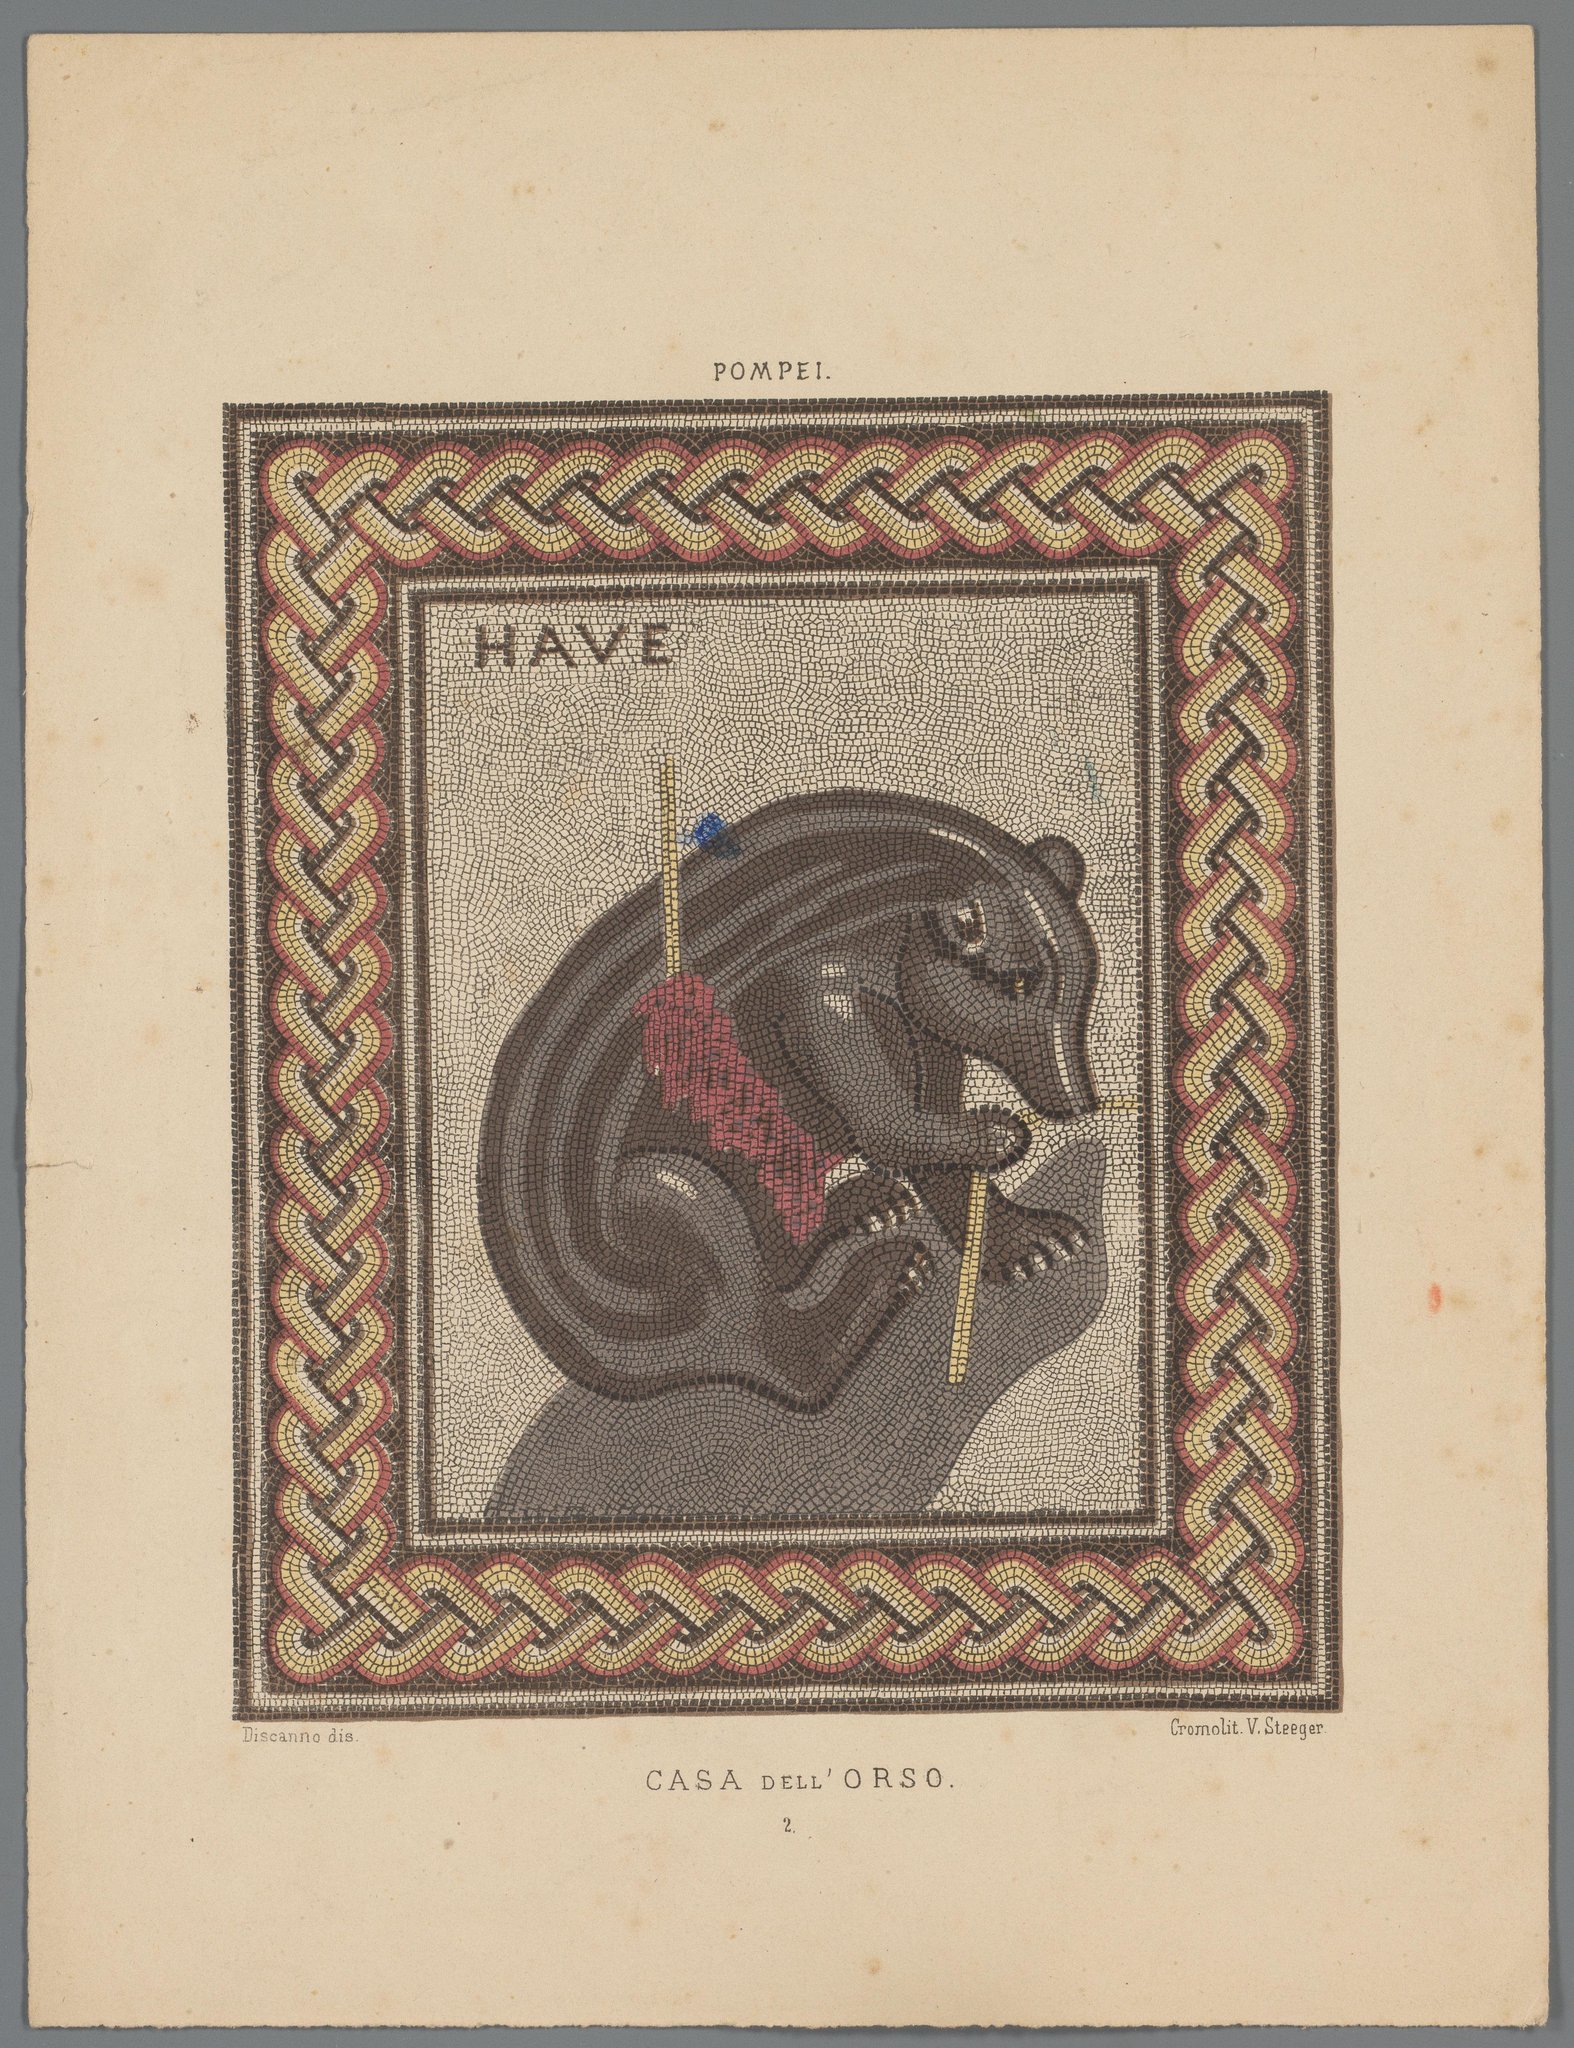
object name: print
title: Pompei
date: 1877-1882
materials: paper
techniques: lithograph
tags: beasts of prey, predatory animals: bear, pompeii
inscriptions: number: ‘2.’